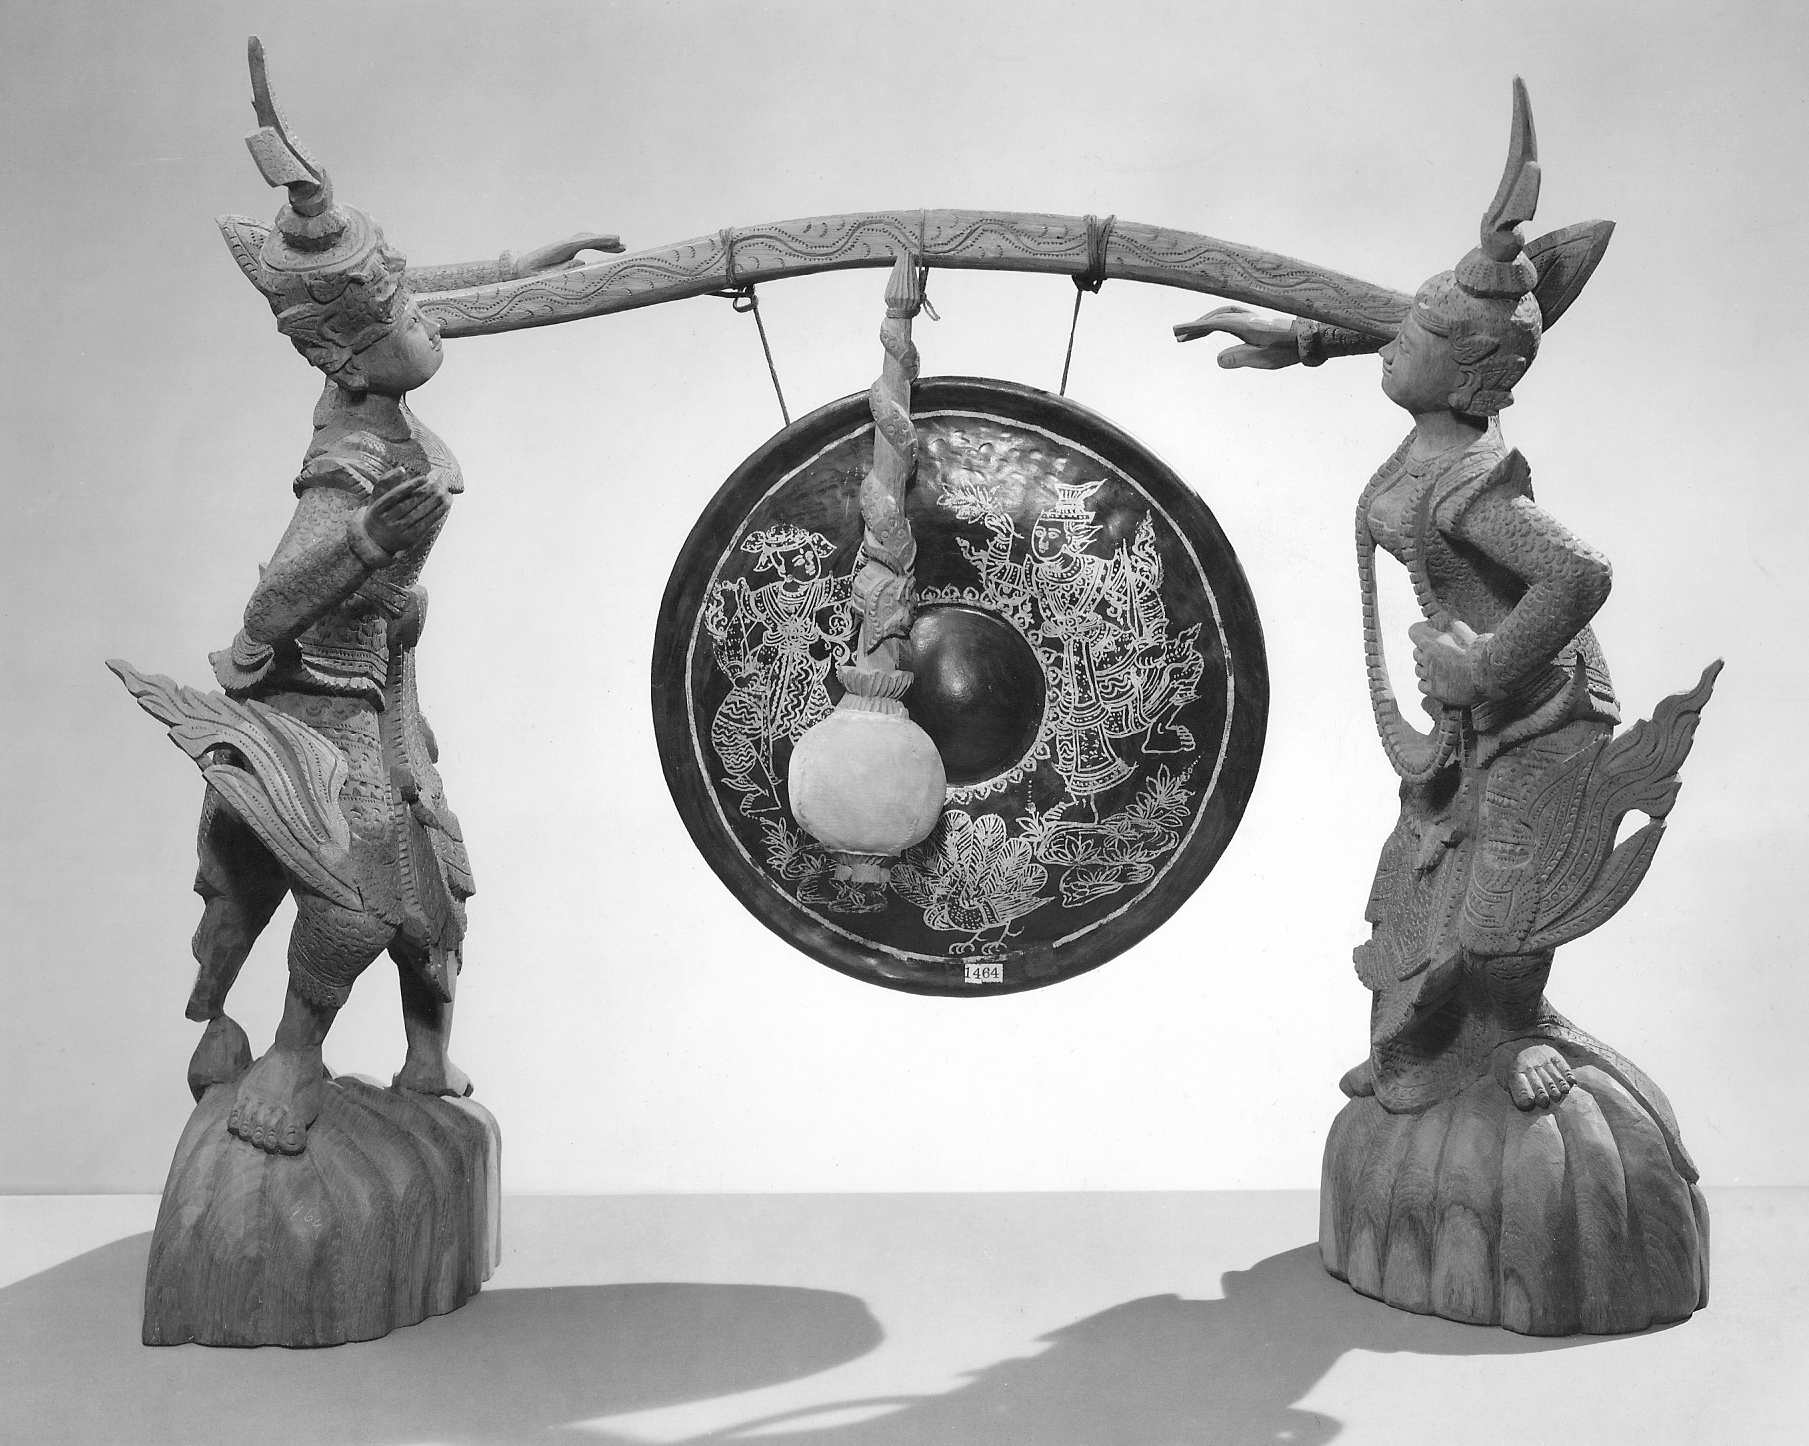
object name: gong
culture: burmese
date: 1867-1900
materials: metal, skin, wood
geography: myanmar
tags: human figures